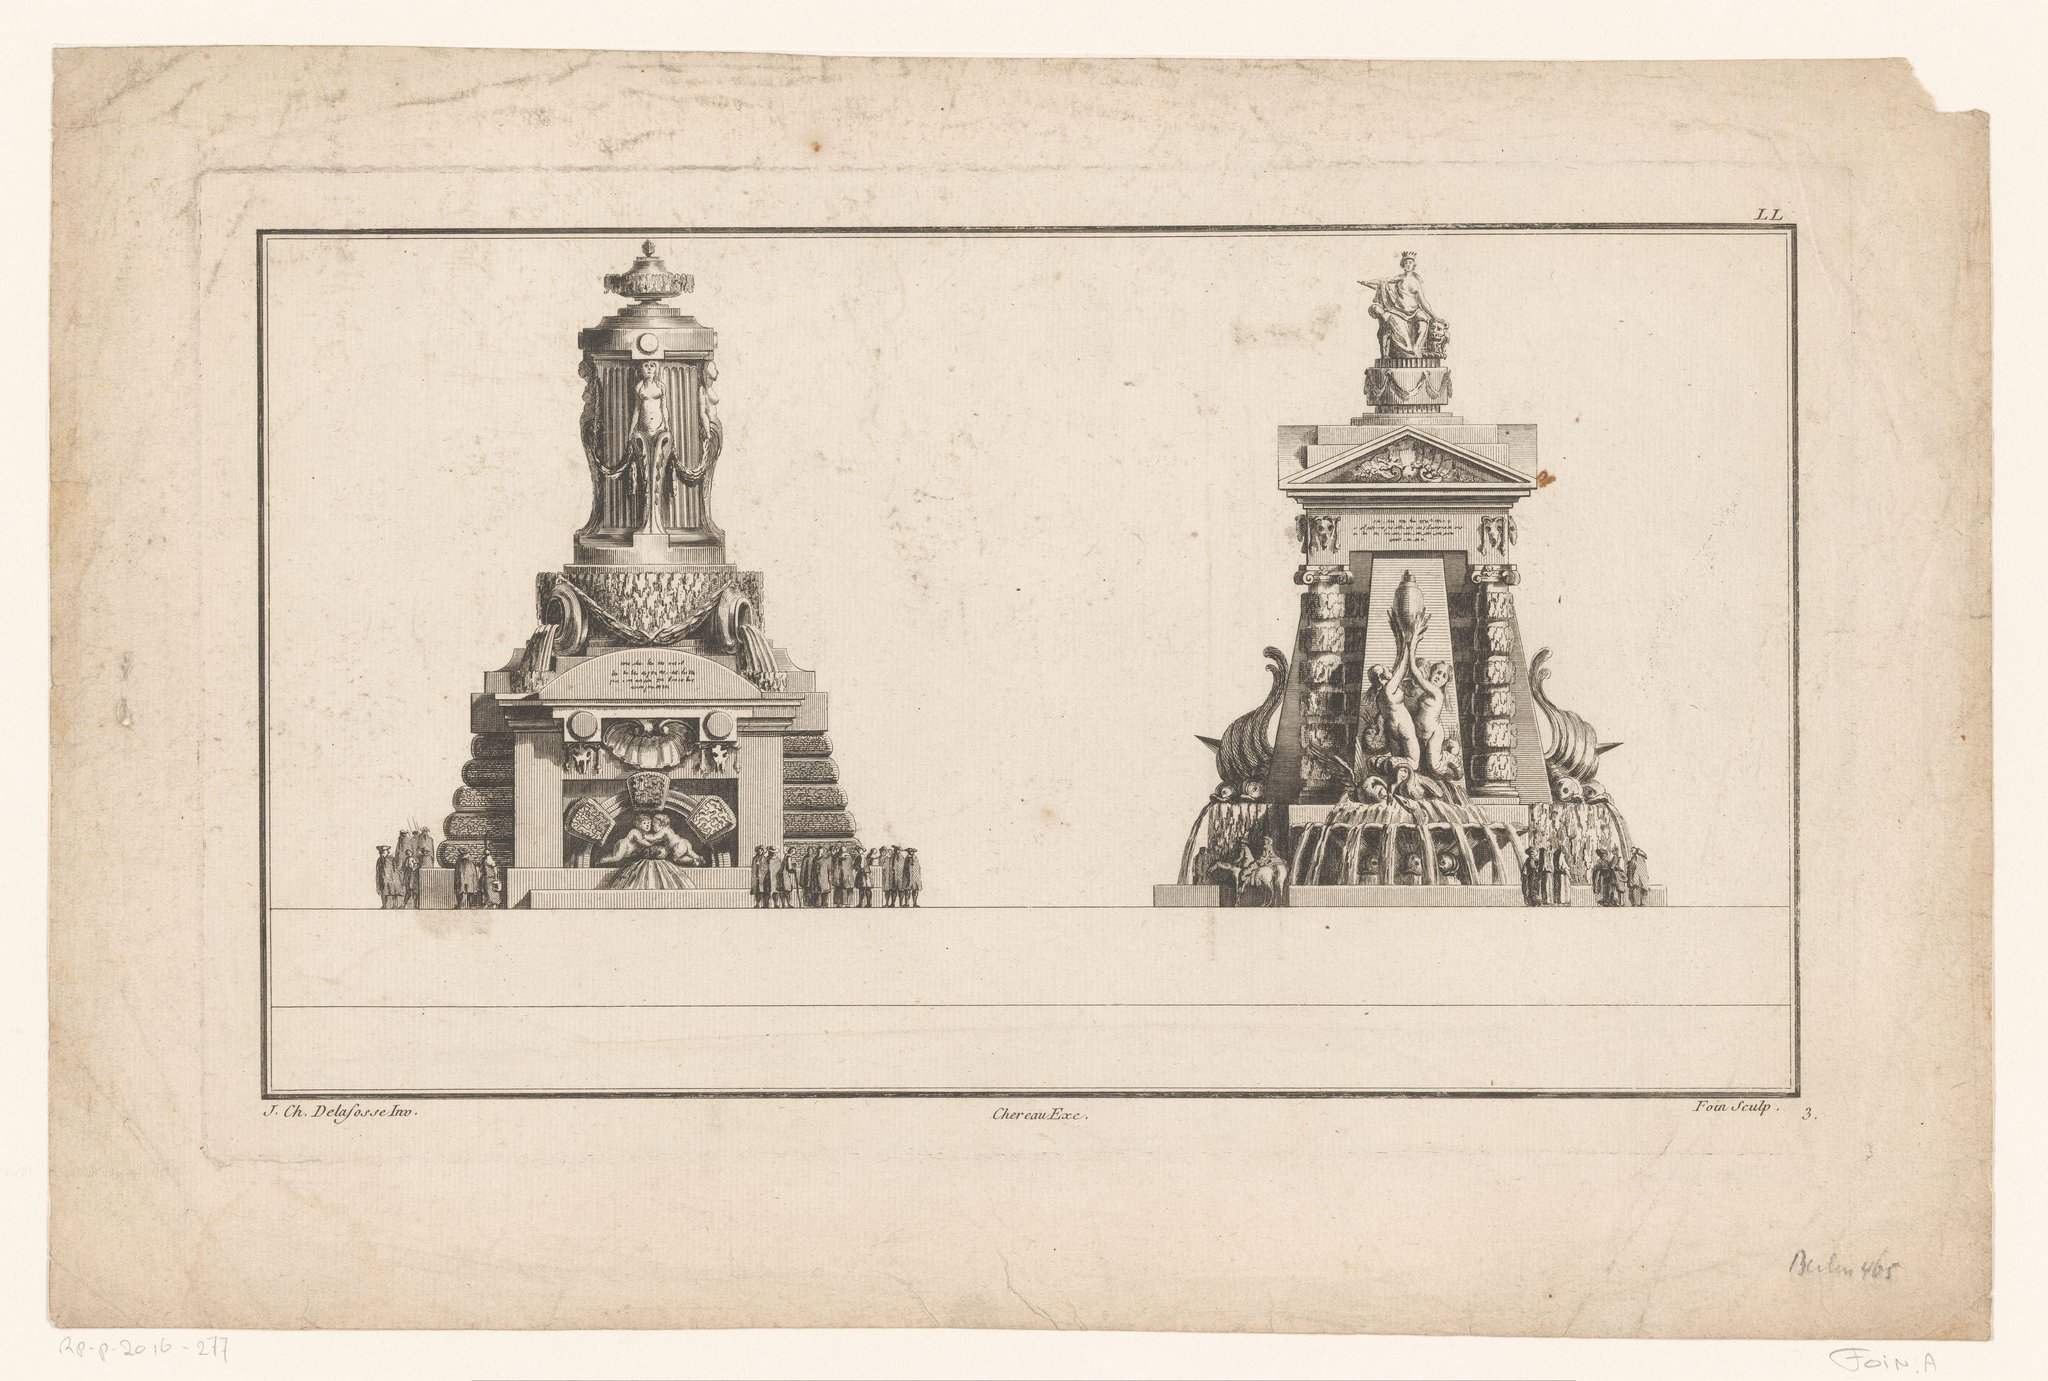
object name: print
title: Twee fonteinen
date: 1771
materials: paper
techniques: engraving, etching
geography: paris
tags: ornamental fountain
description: Links een fontein met putti, bucraniums, een schelpmotief, halffiguren en een vaas. Rechts een fontein met dolfijnen, meerminnen, zwanen, zuilen, een fronton en een gekroonde vrouw.